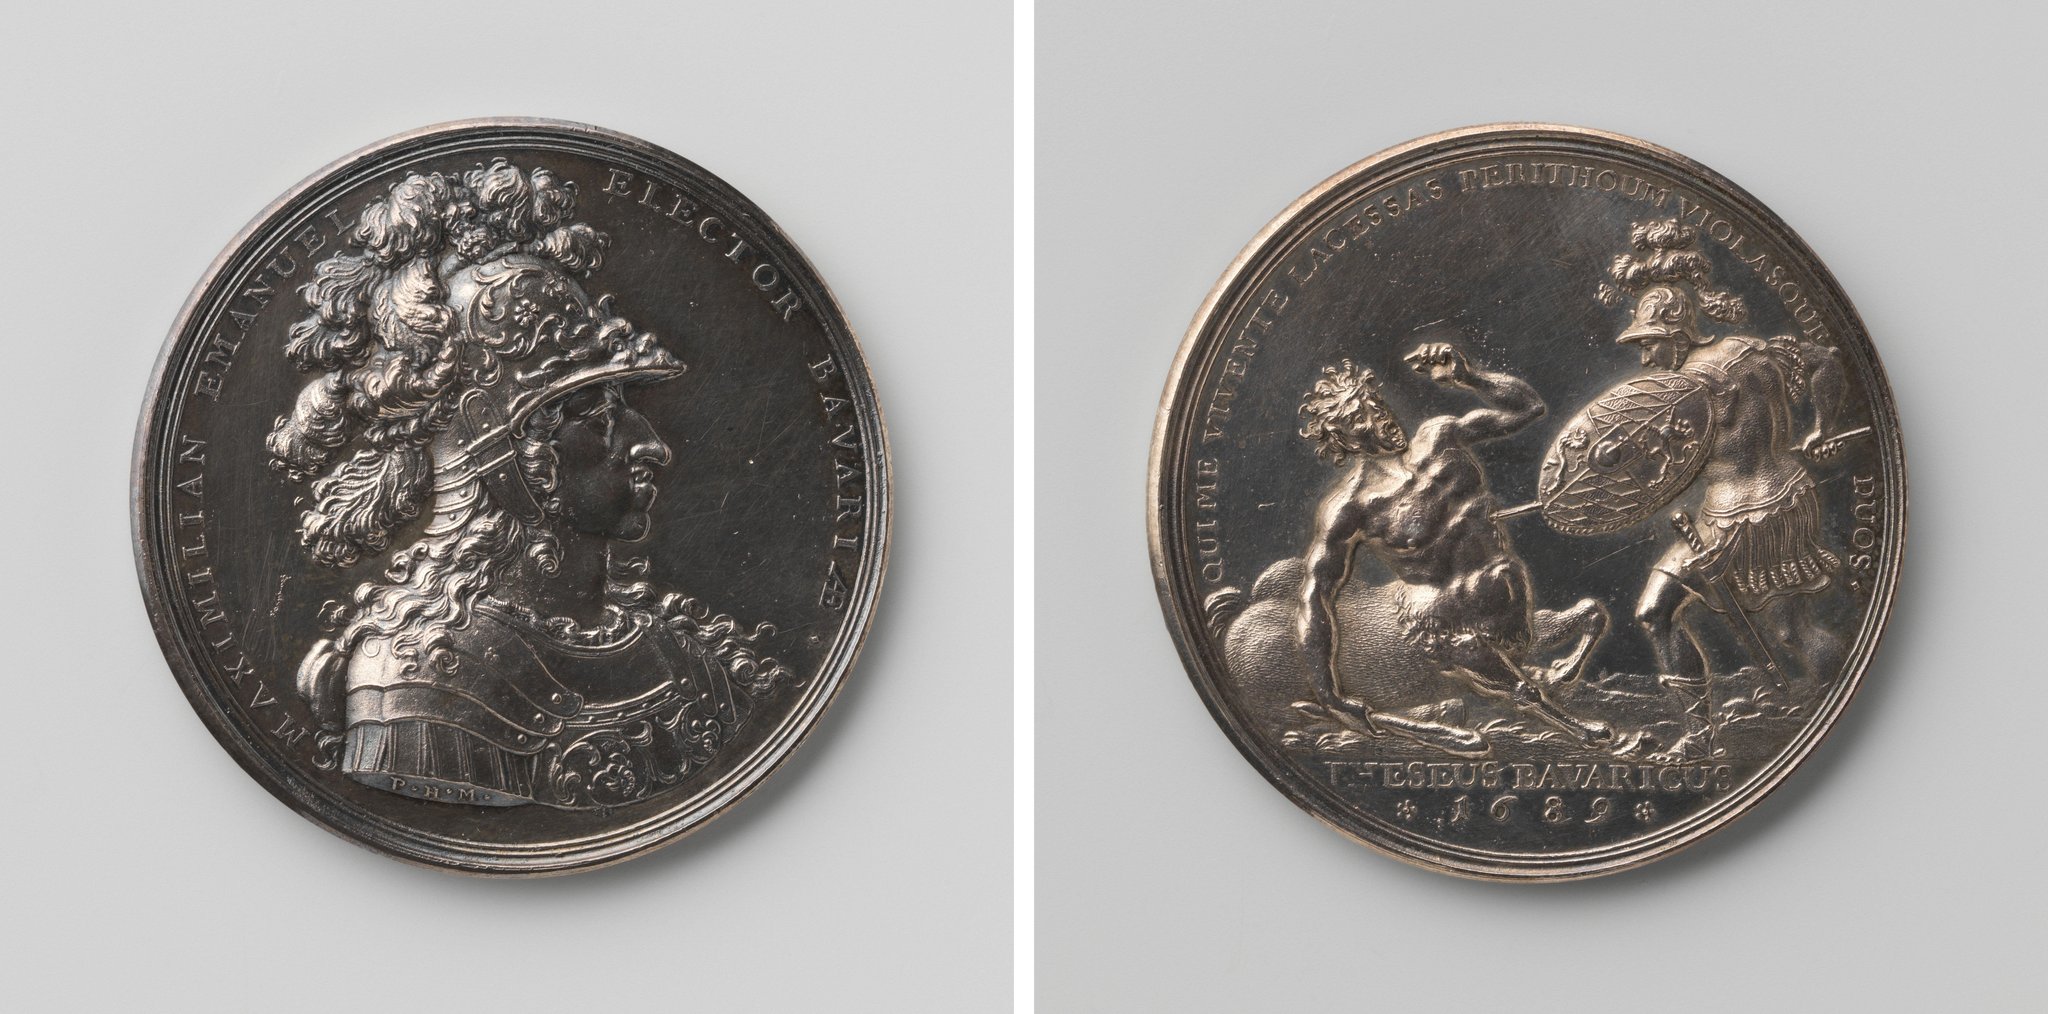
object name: history medal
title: Krijgstocht van Maximiliaan Emanuel, keurvorst van Beieren tegen de Fransen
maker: philipp heinrich müller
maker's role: medailleur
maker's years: 1654-1719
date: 1689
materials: silver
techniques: striking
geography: nuremberg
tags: maximiliaan ii emanuel (keurvorst van beieren)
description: Zilveren penning. Voorzijde: borststuk man met helm binnen omschrift. Keerzijde: Maximiliaan afgebeeld als gehelmde Theseus met wapenschild doodt met speer de centaur Eurytus binnen omschrift; afsnede: opschrift